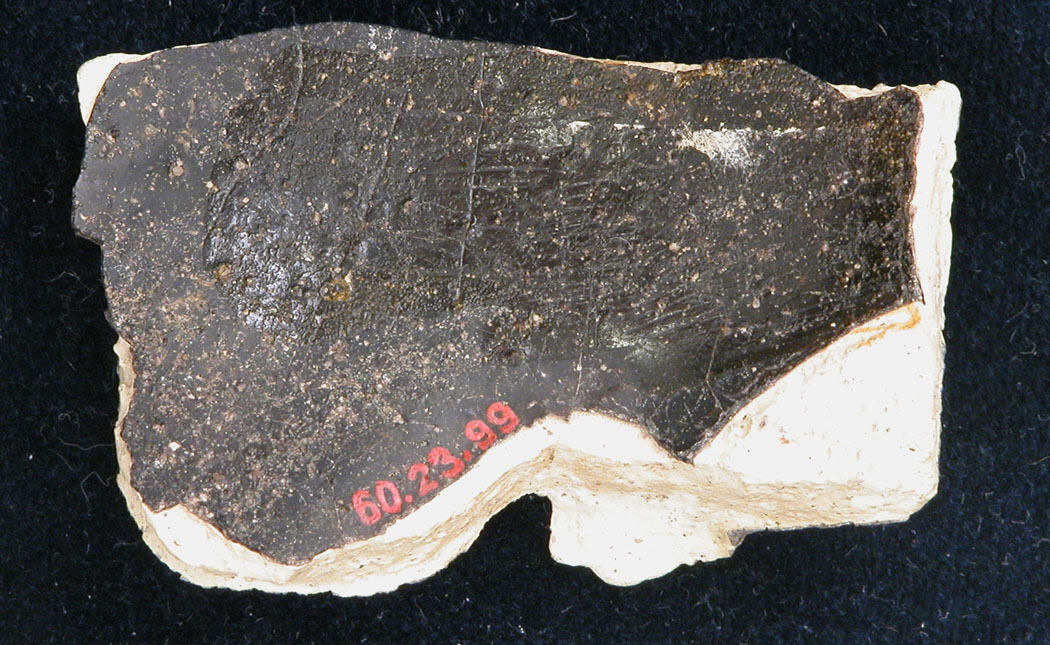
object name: fragment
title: Ceramic Fragment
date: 801-1000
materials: earthenware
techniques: glazing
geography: saudi arabia